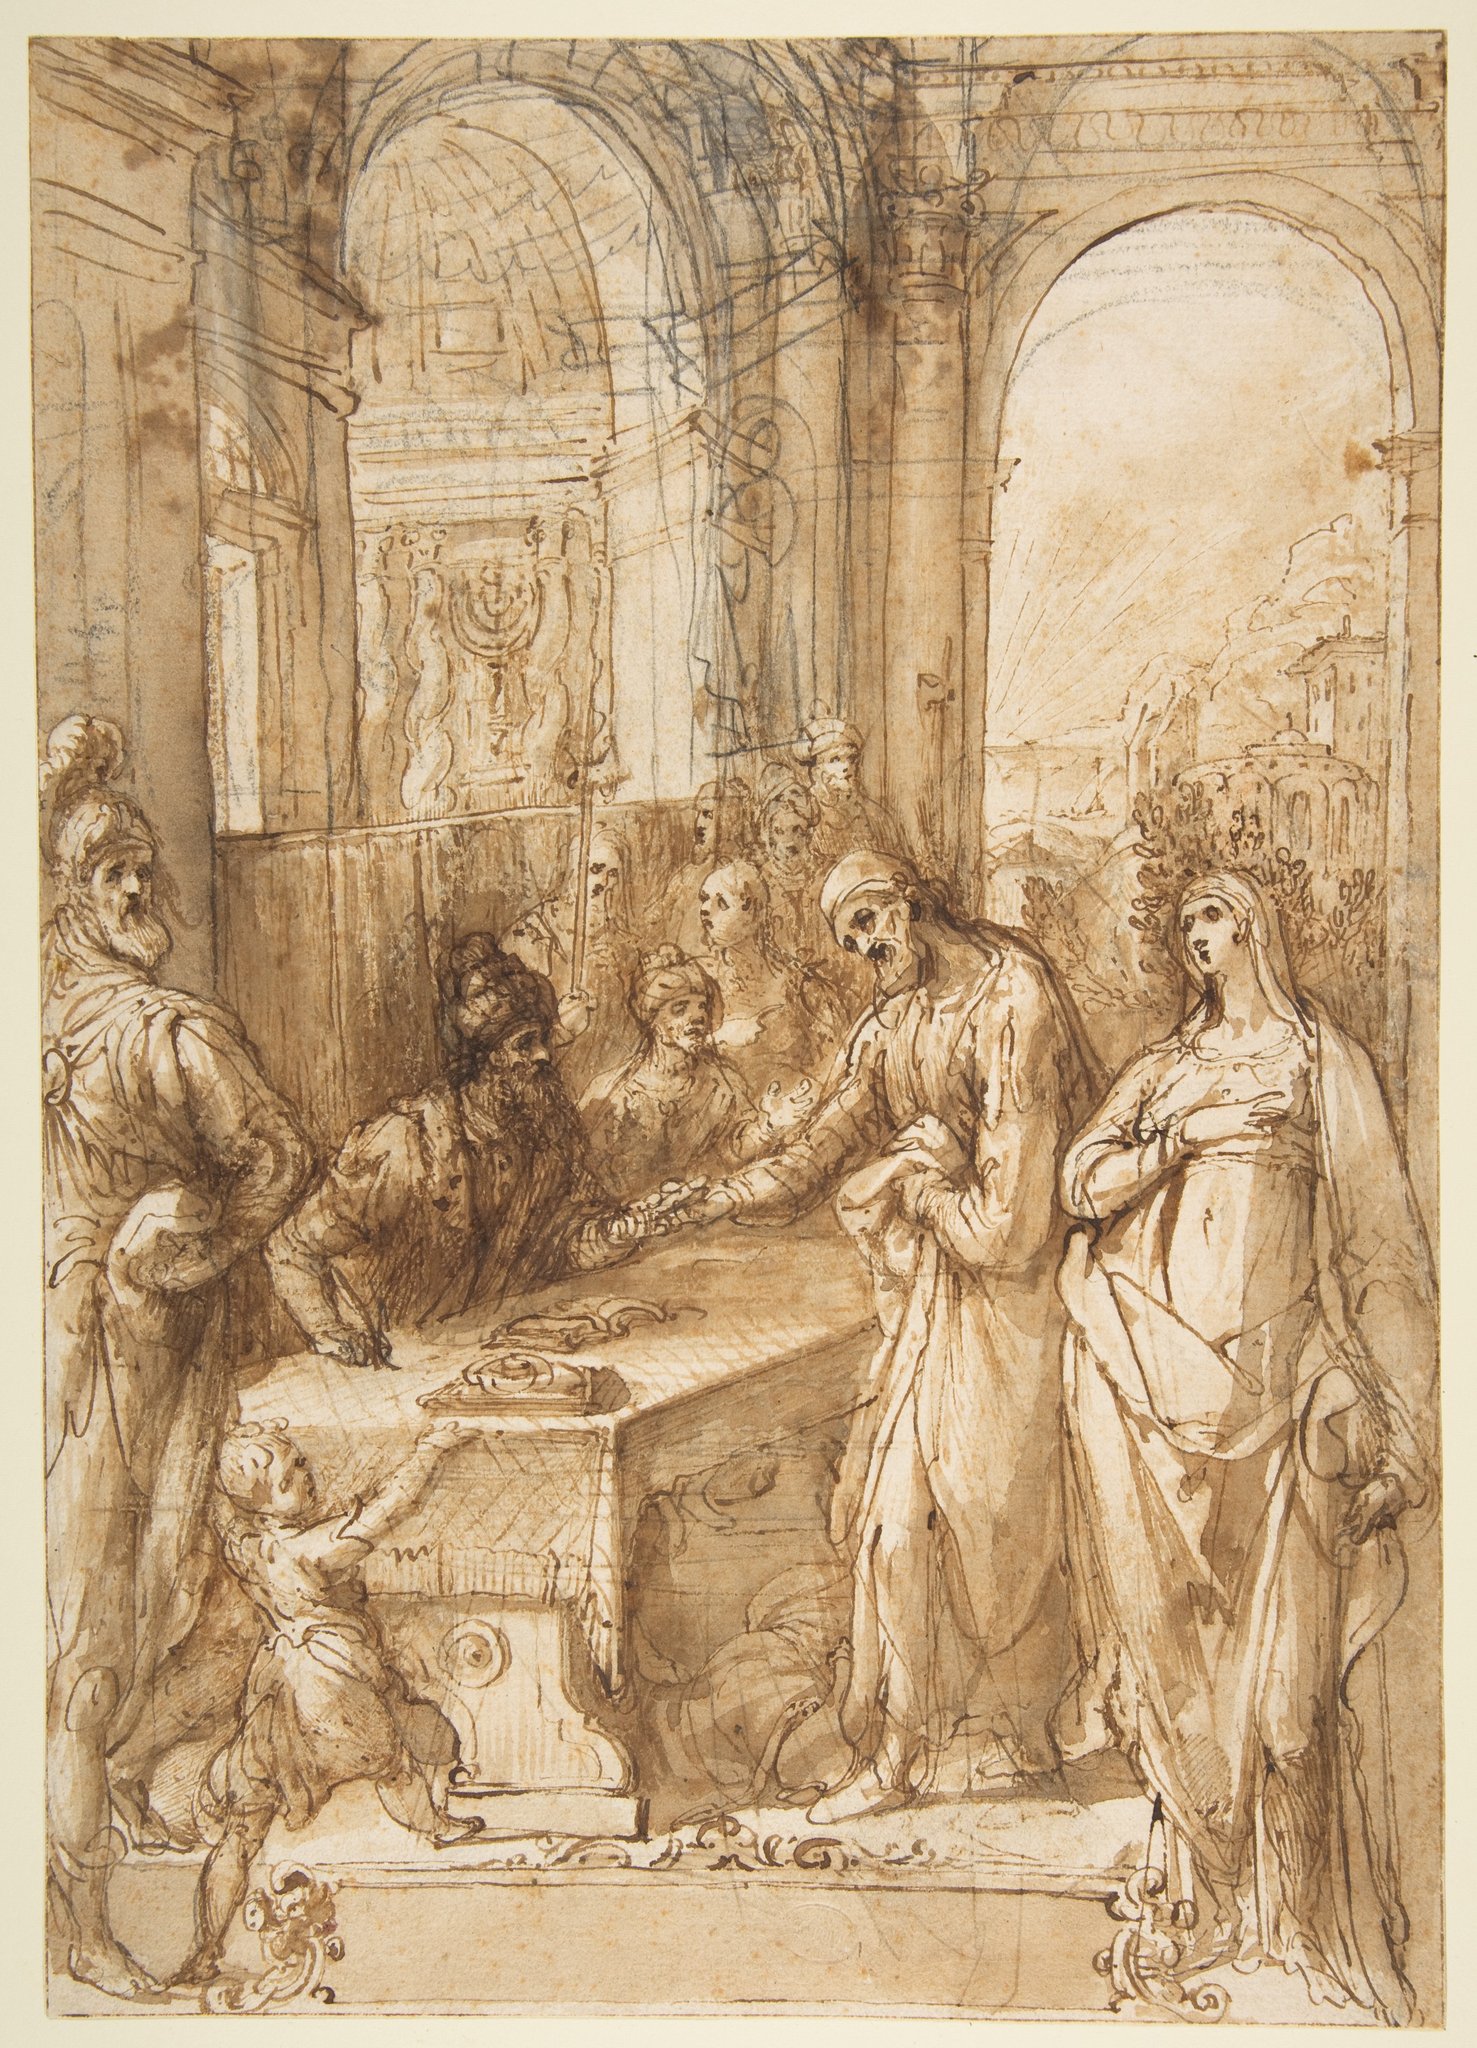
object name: drawing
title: Esther and Mordecai before King Ahasuerus (Esther 8:1- 12)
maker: giovanni de' vecchi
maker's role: artist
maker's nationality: italian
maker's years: 1536-1615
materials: chalk, ink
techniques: brush, pen, wash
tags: kings,men,women,esther,ahasuerus